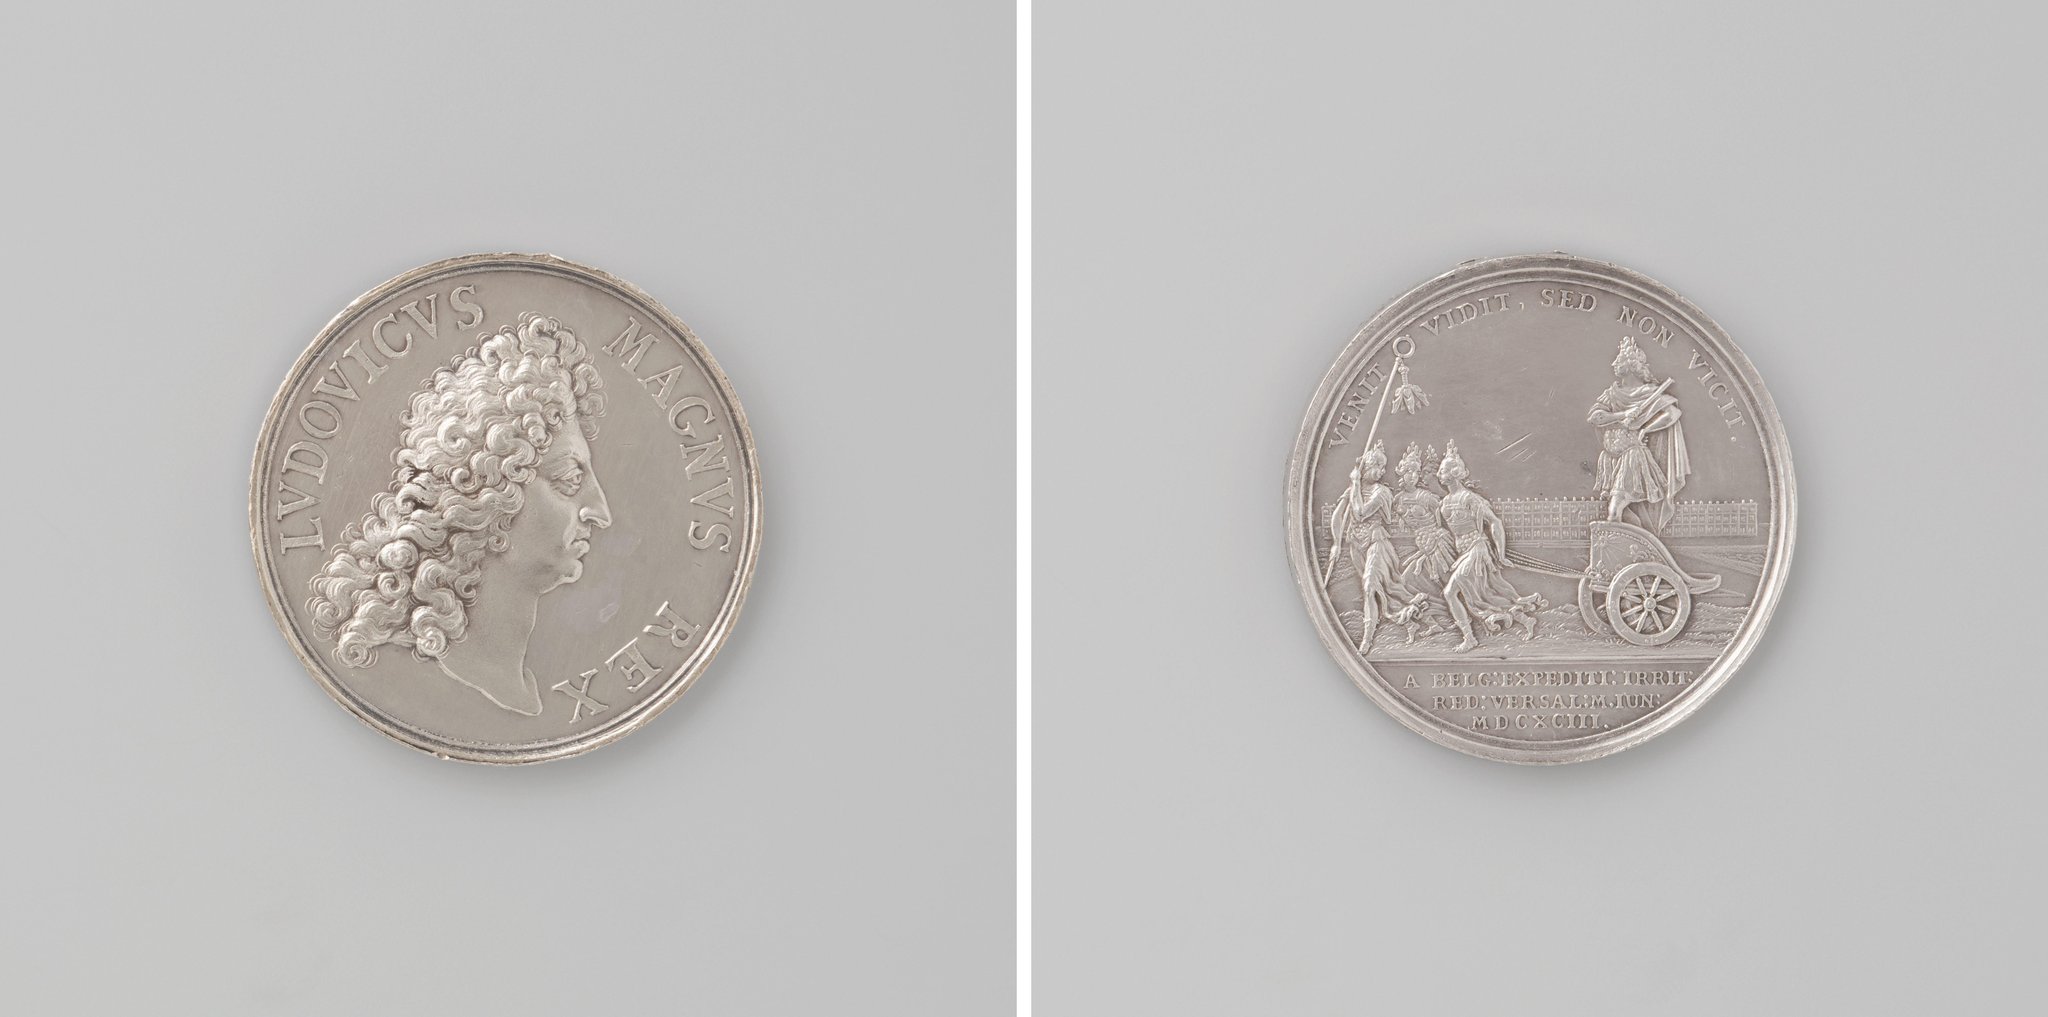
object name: satirical medal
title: Snelle terugkeer van Lodewijk XIV van Namen naar Versailles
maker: jan smeltzing (i)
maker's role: modelleur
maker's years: 1656-1693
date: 1693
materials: silver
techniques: striking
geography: leiden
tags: lodewijk xiv (koning van frankrijk)